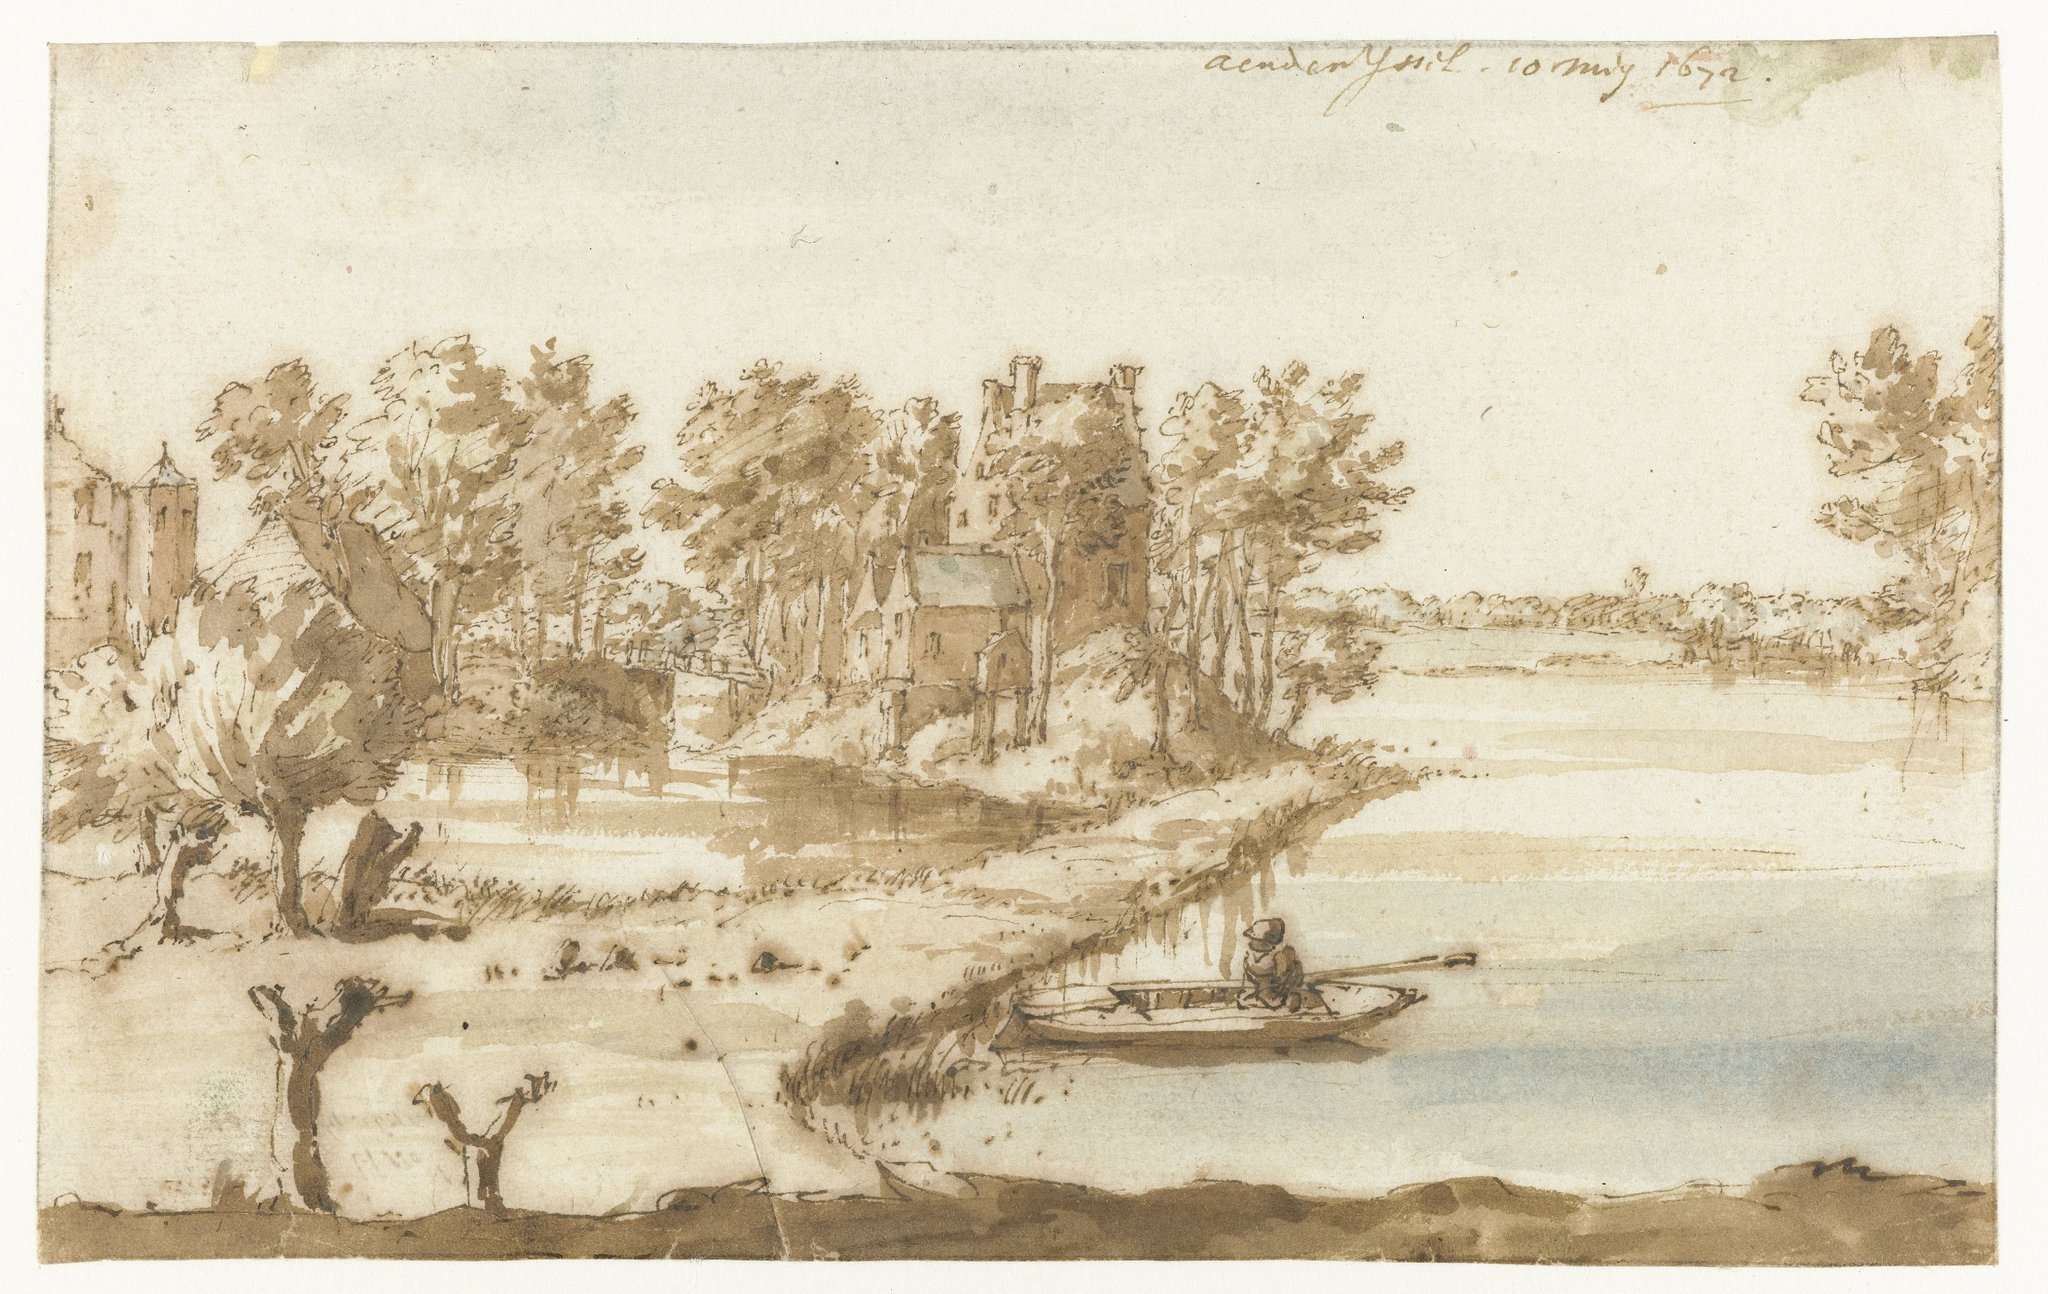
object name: drawing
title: Oude Poll bij Wilp aan de IJssel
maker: constantijn huygens (ii)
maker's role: draughtsman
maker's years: 1628-1697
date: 1672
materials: paper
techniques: brush, pen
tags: castle, river